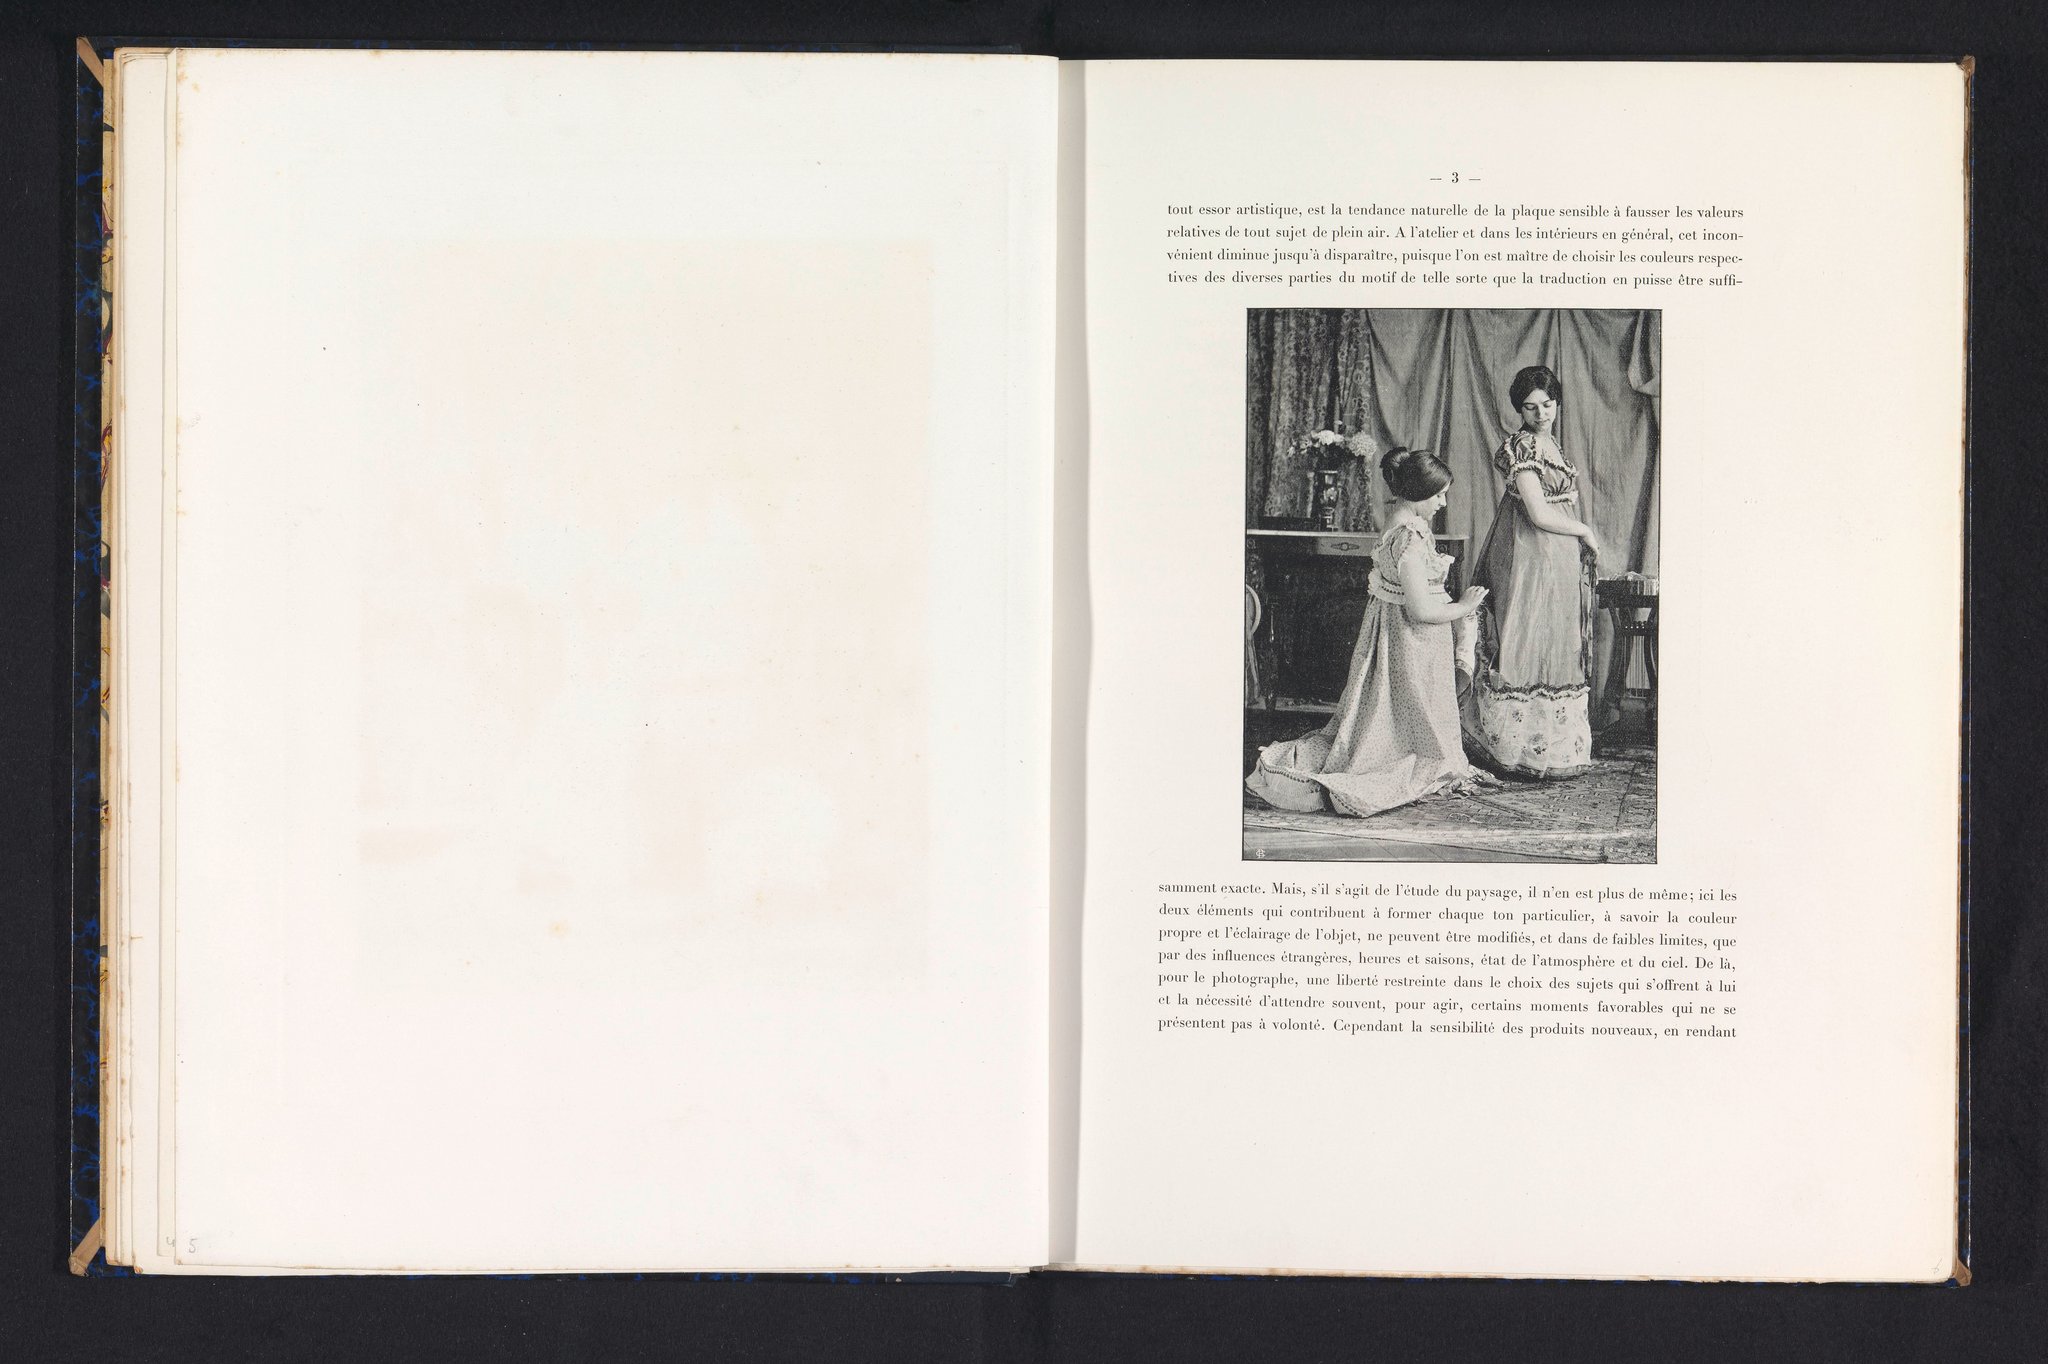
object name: photomechanical print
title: Knielende vrouw verstelt een jurk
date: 1886-1896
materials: paper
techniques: autotype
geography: france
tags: mending, repairing ~ clothes, adult woman, interior ~ representation of a building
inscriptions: inscription: ‘CB’